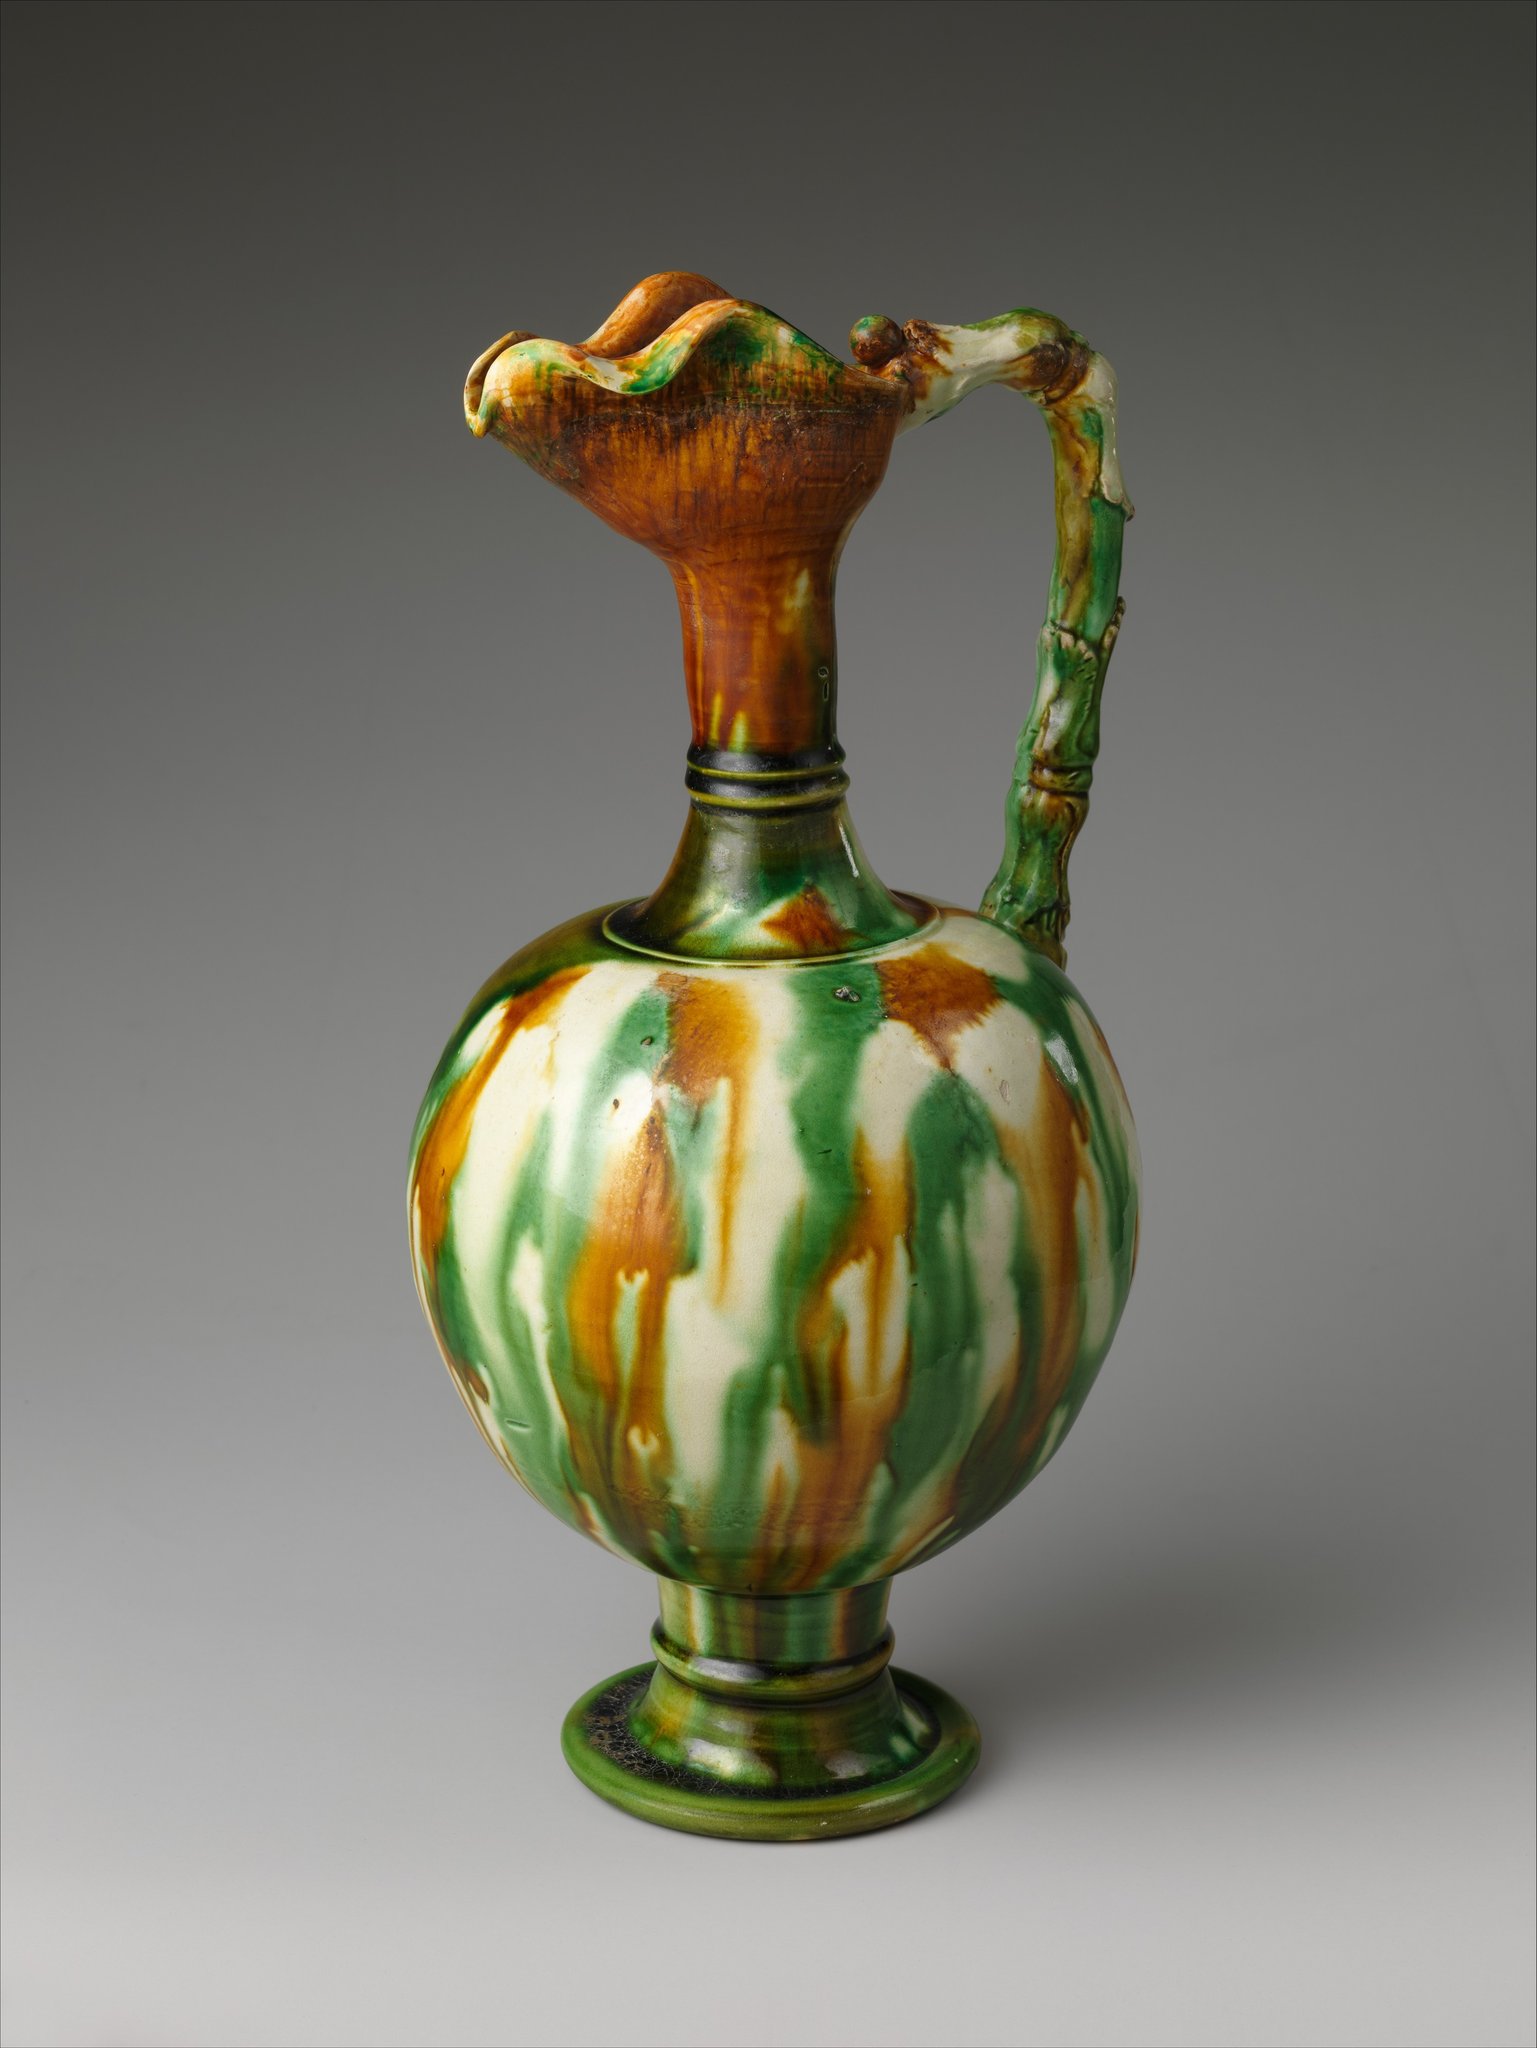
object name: ewer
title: Amphora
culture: chinese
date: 667-700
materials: earthenware, glaze